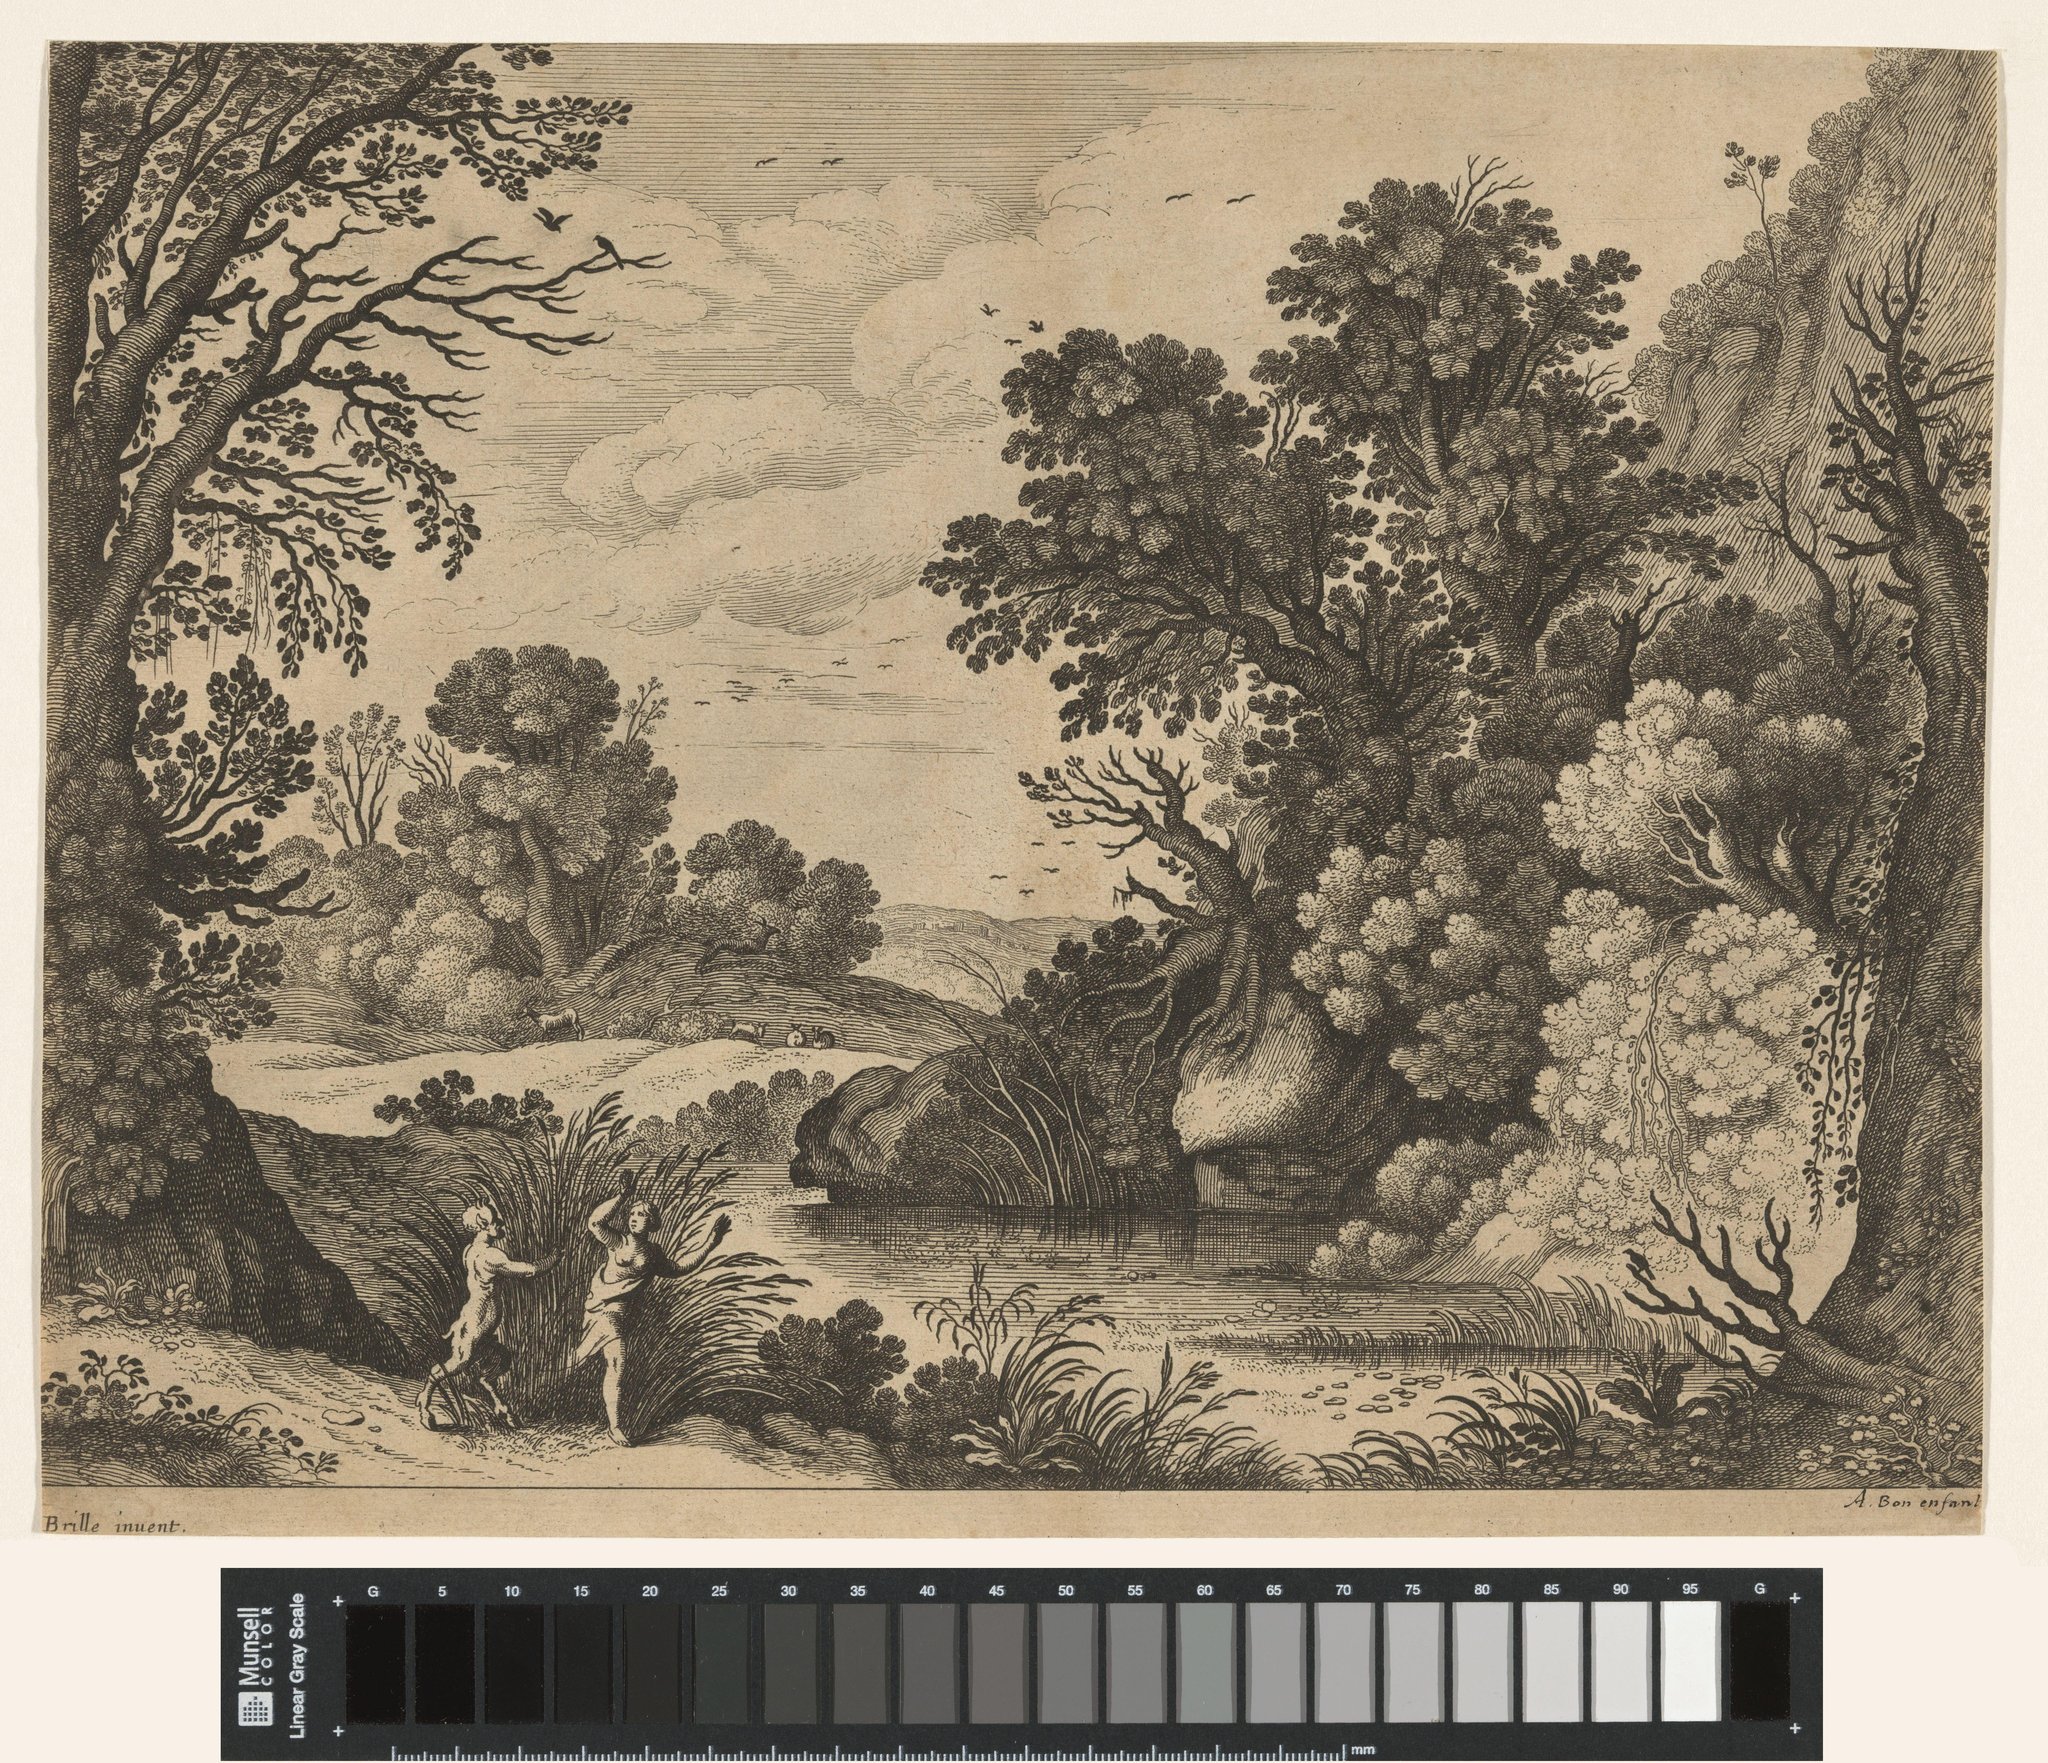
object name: print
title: Pan en Syrinx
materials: paper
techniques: etching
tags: river, syrinx changed into a reed: while fleeing from pan, the nymph syrinx is changed into reed by her sisters, the naiads (ovid, metamorphoses i 705)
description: Pan achtervolgt Syrinx, maar zij verandert in riethalmen als ze bij de rivier is. Pan omarmt het riet.